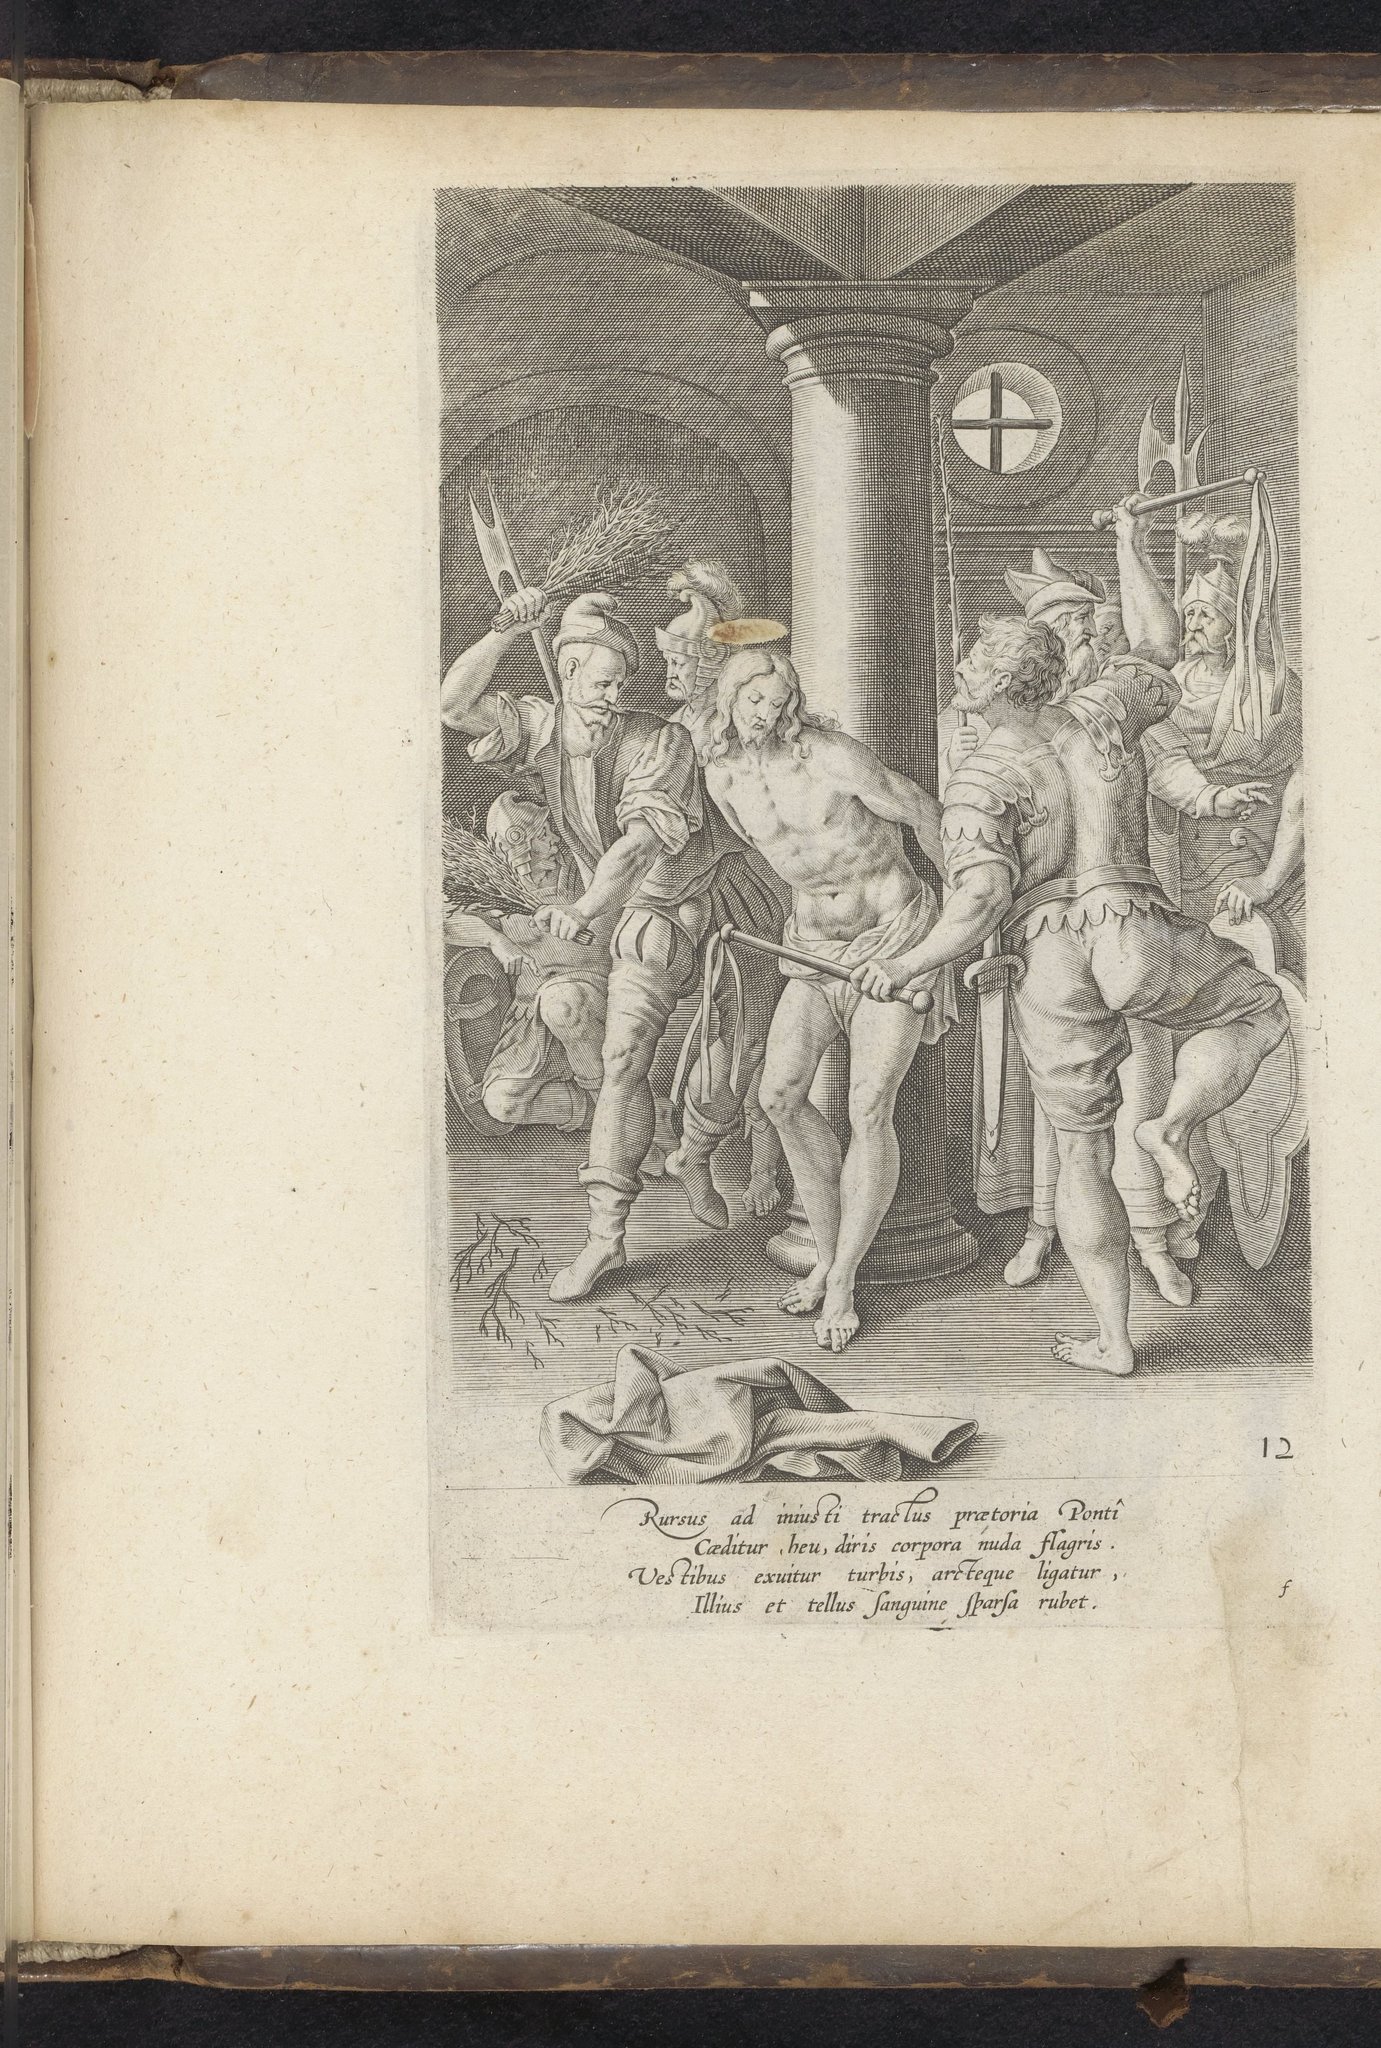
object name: print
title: Den Grooten Figuer-Bibel (...)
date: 1585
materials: paper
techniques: engraving, hand coloring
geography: amsterdam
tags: flagellation by soldiers, christ usually tied to a column (matthew 27:26; mark 15:15; john 19:1)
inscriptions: number: ‘138’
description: Christus, gekleed in een lendendoek en vastgebonden aan een pilaar, wordt door soldaten geschopt en gegeseld. Onder de voorstelling een vierregelig vers in het Latijn. Rechtsonder de letter: f. Deze prent maakt deel uit van een album.